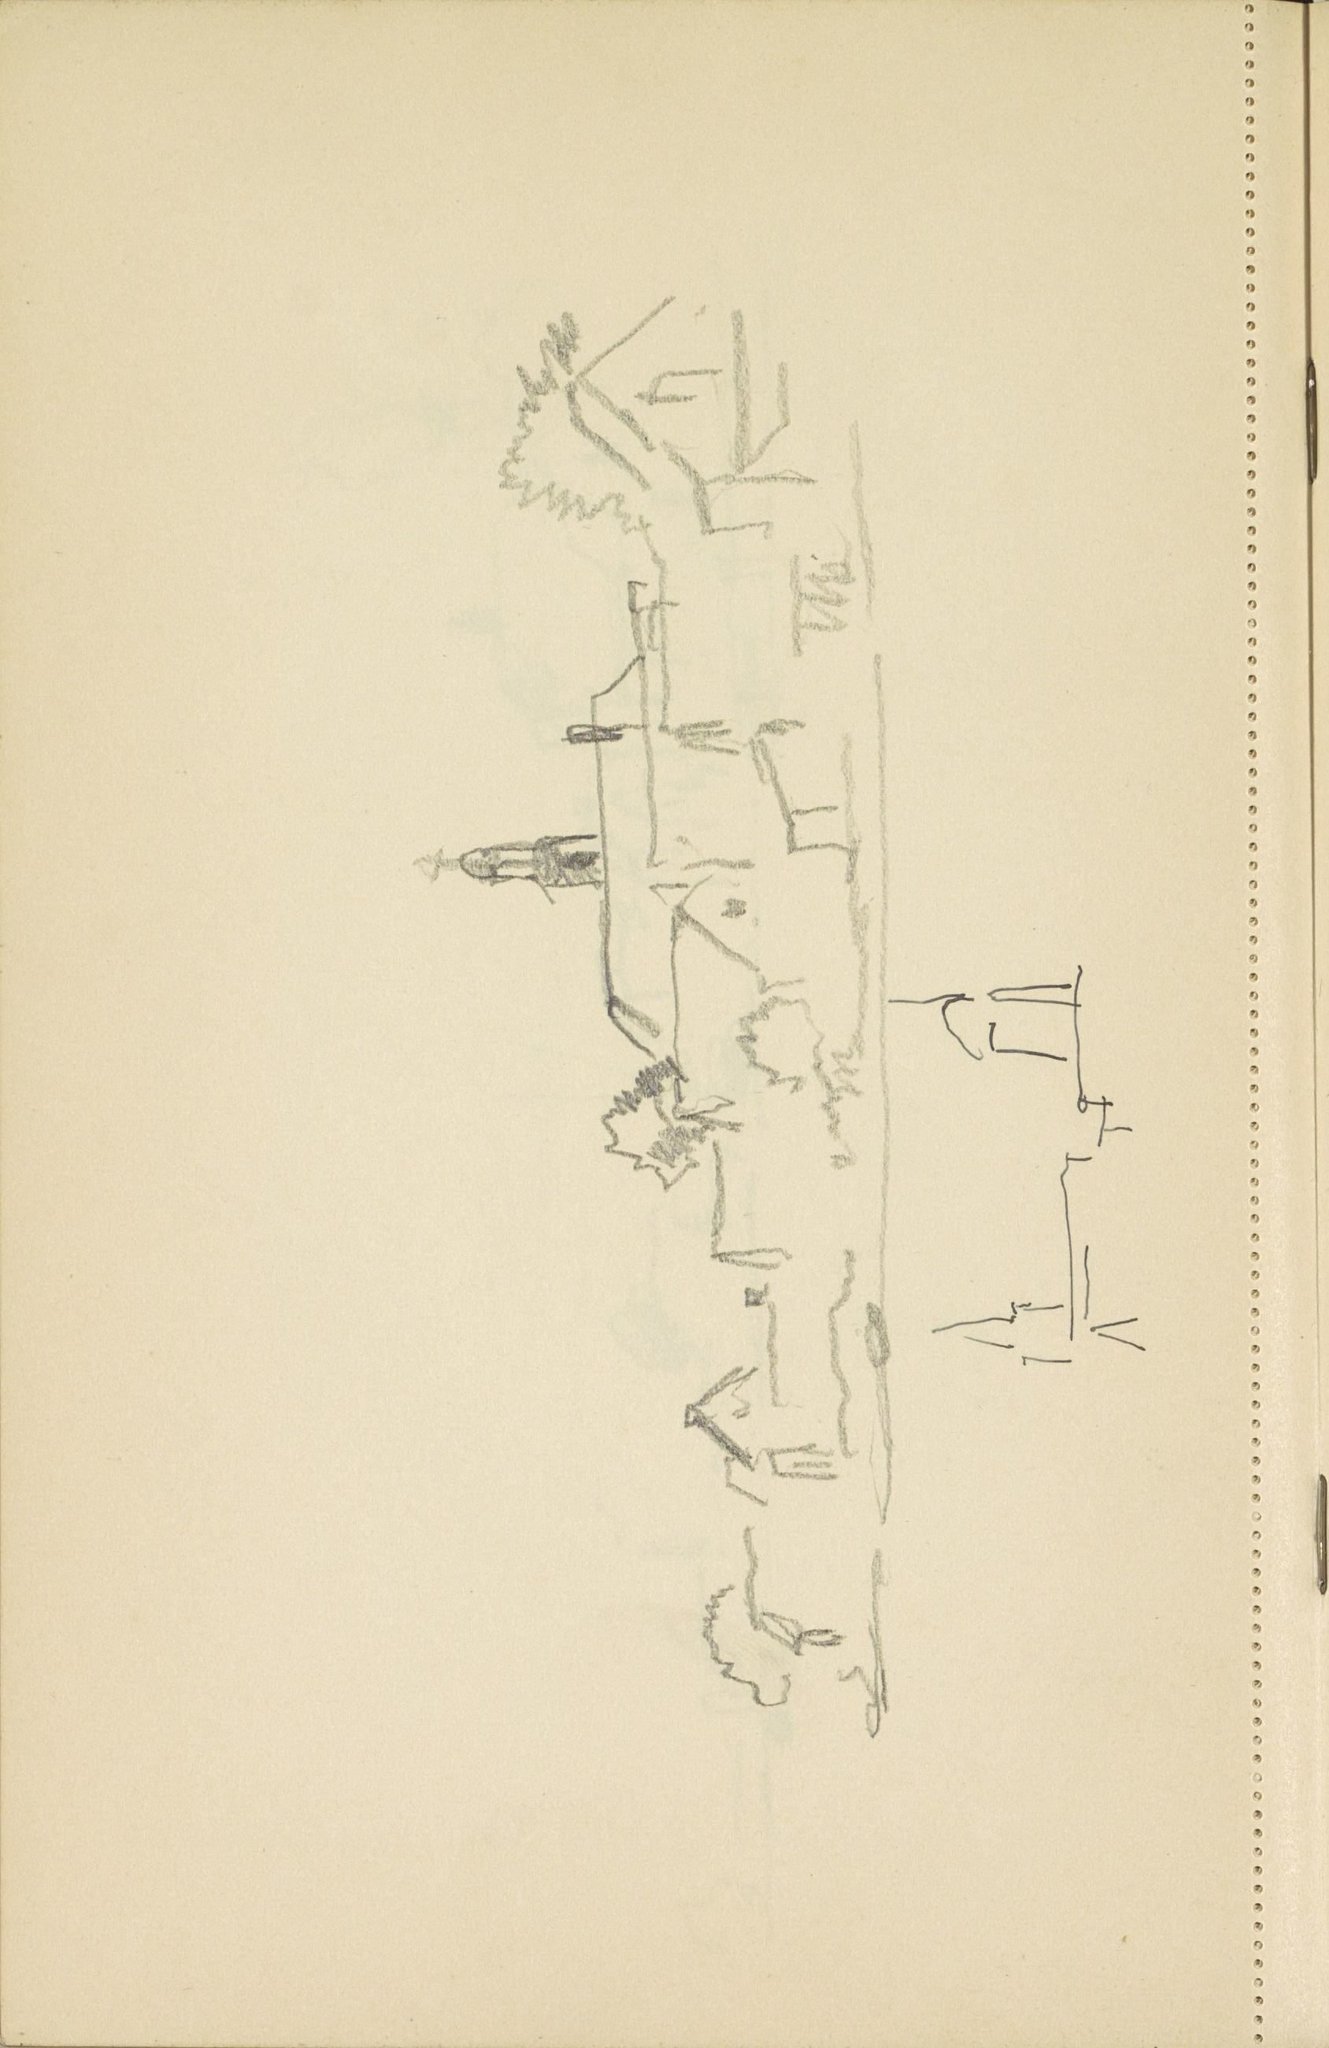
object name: sketchbook leaf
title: Huizen en een kerk met een toren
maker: cornelis vreedenburgh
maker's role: draughtsman, print maker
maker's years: 1880-1946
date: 1890-1946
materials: ink, paper, pencil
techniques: pen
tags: city-view, and landscape with man-made constructions, parts of church exterior and annexes: tower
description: Blad 58 verso uit een schetsboek met 73 bladen.